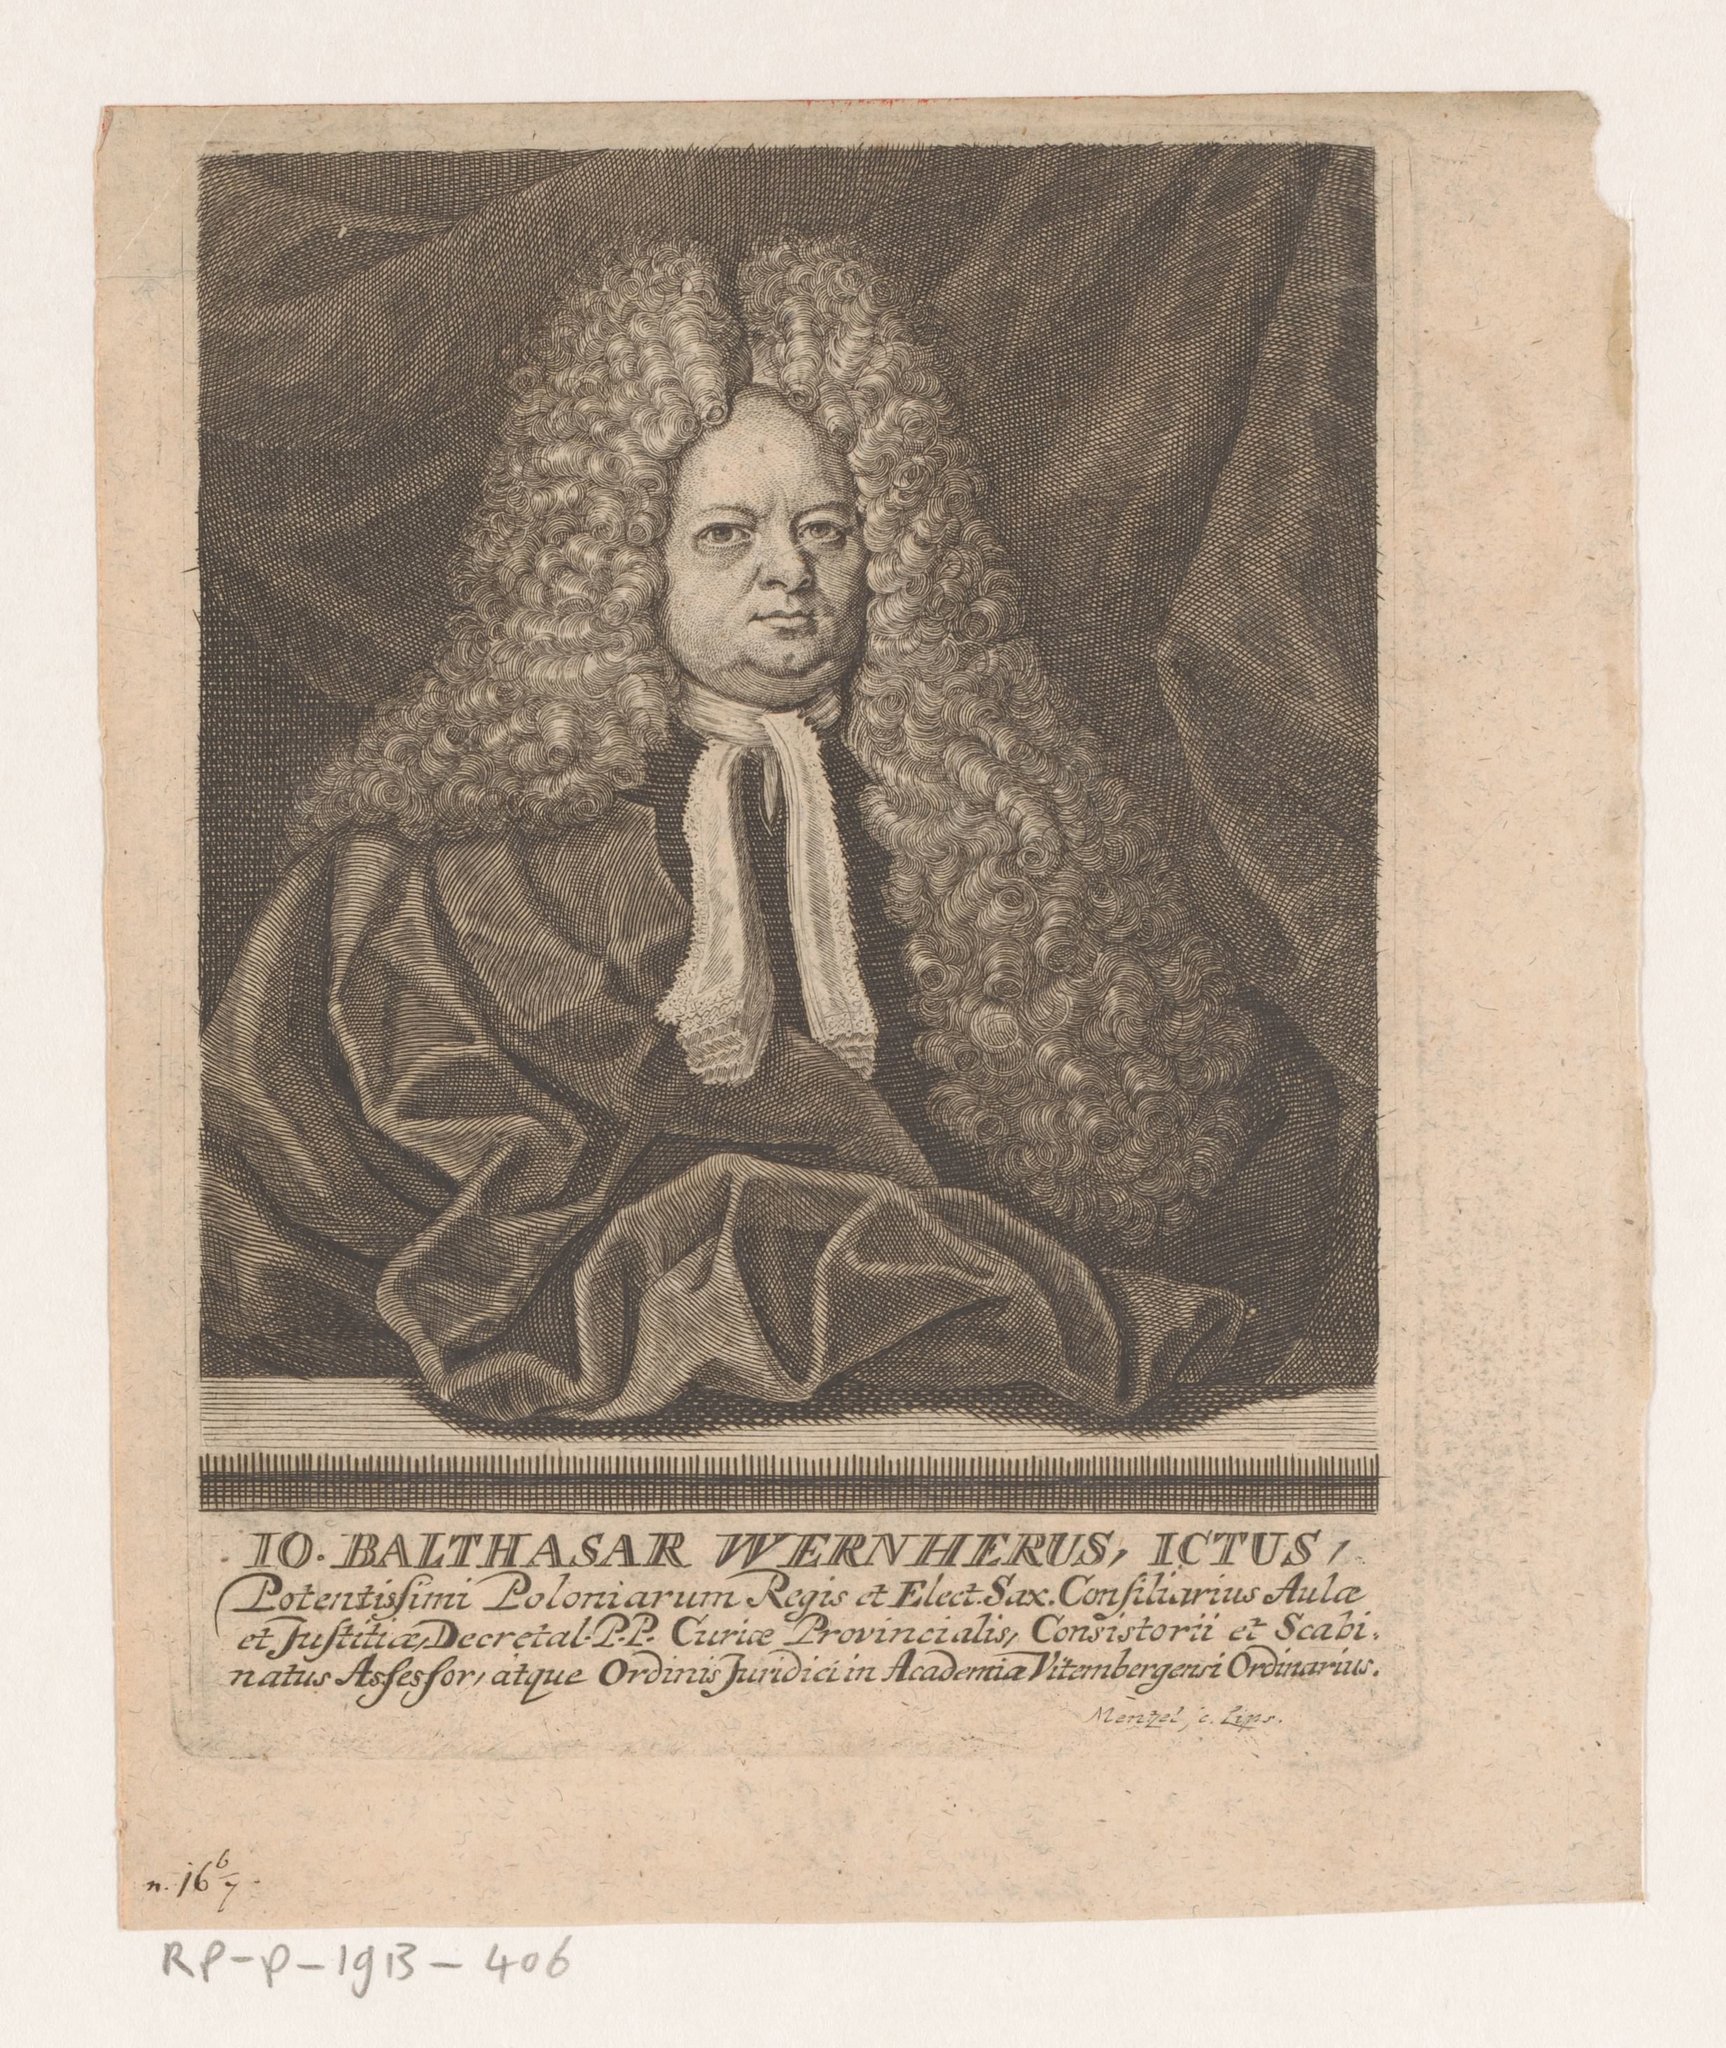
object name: print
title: Portret van Johann Balthasar Wernher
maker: johann georg mentzel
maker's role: print maker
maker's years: 1677-1743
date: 1687-1743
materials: paper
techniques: engraving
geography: leipzig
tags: johann balthasar wernher, historical persons, wig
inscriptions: collector's mark: Lugt 2228